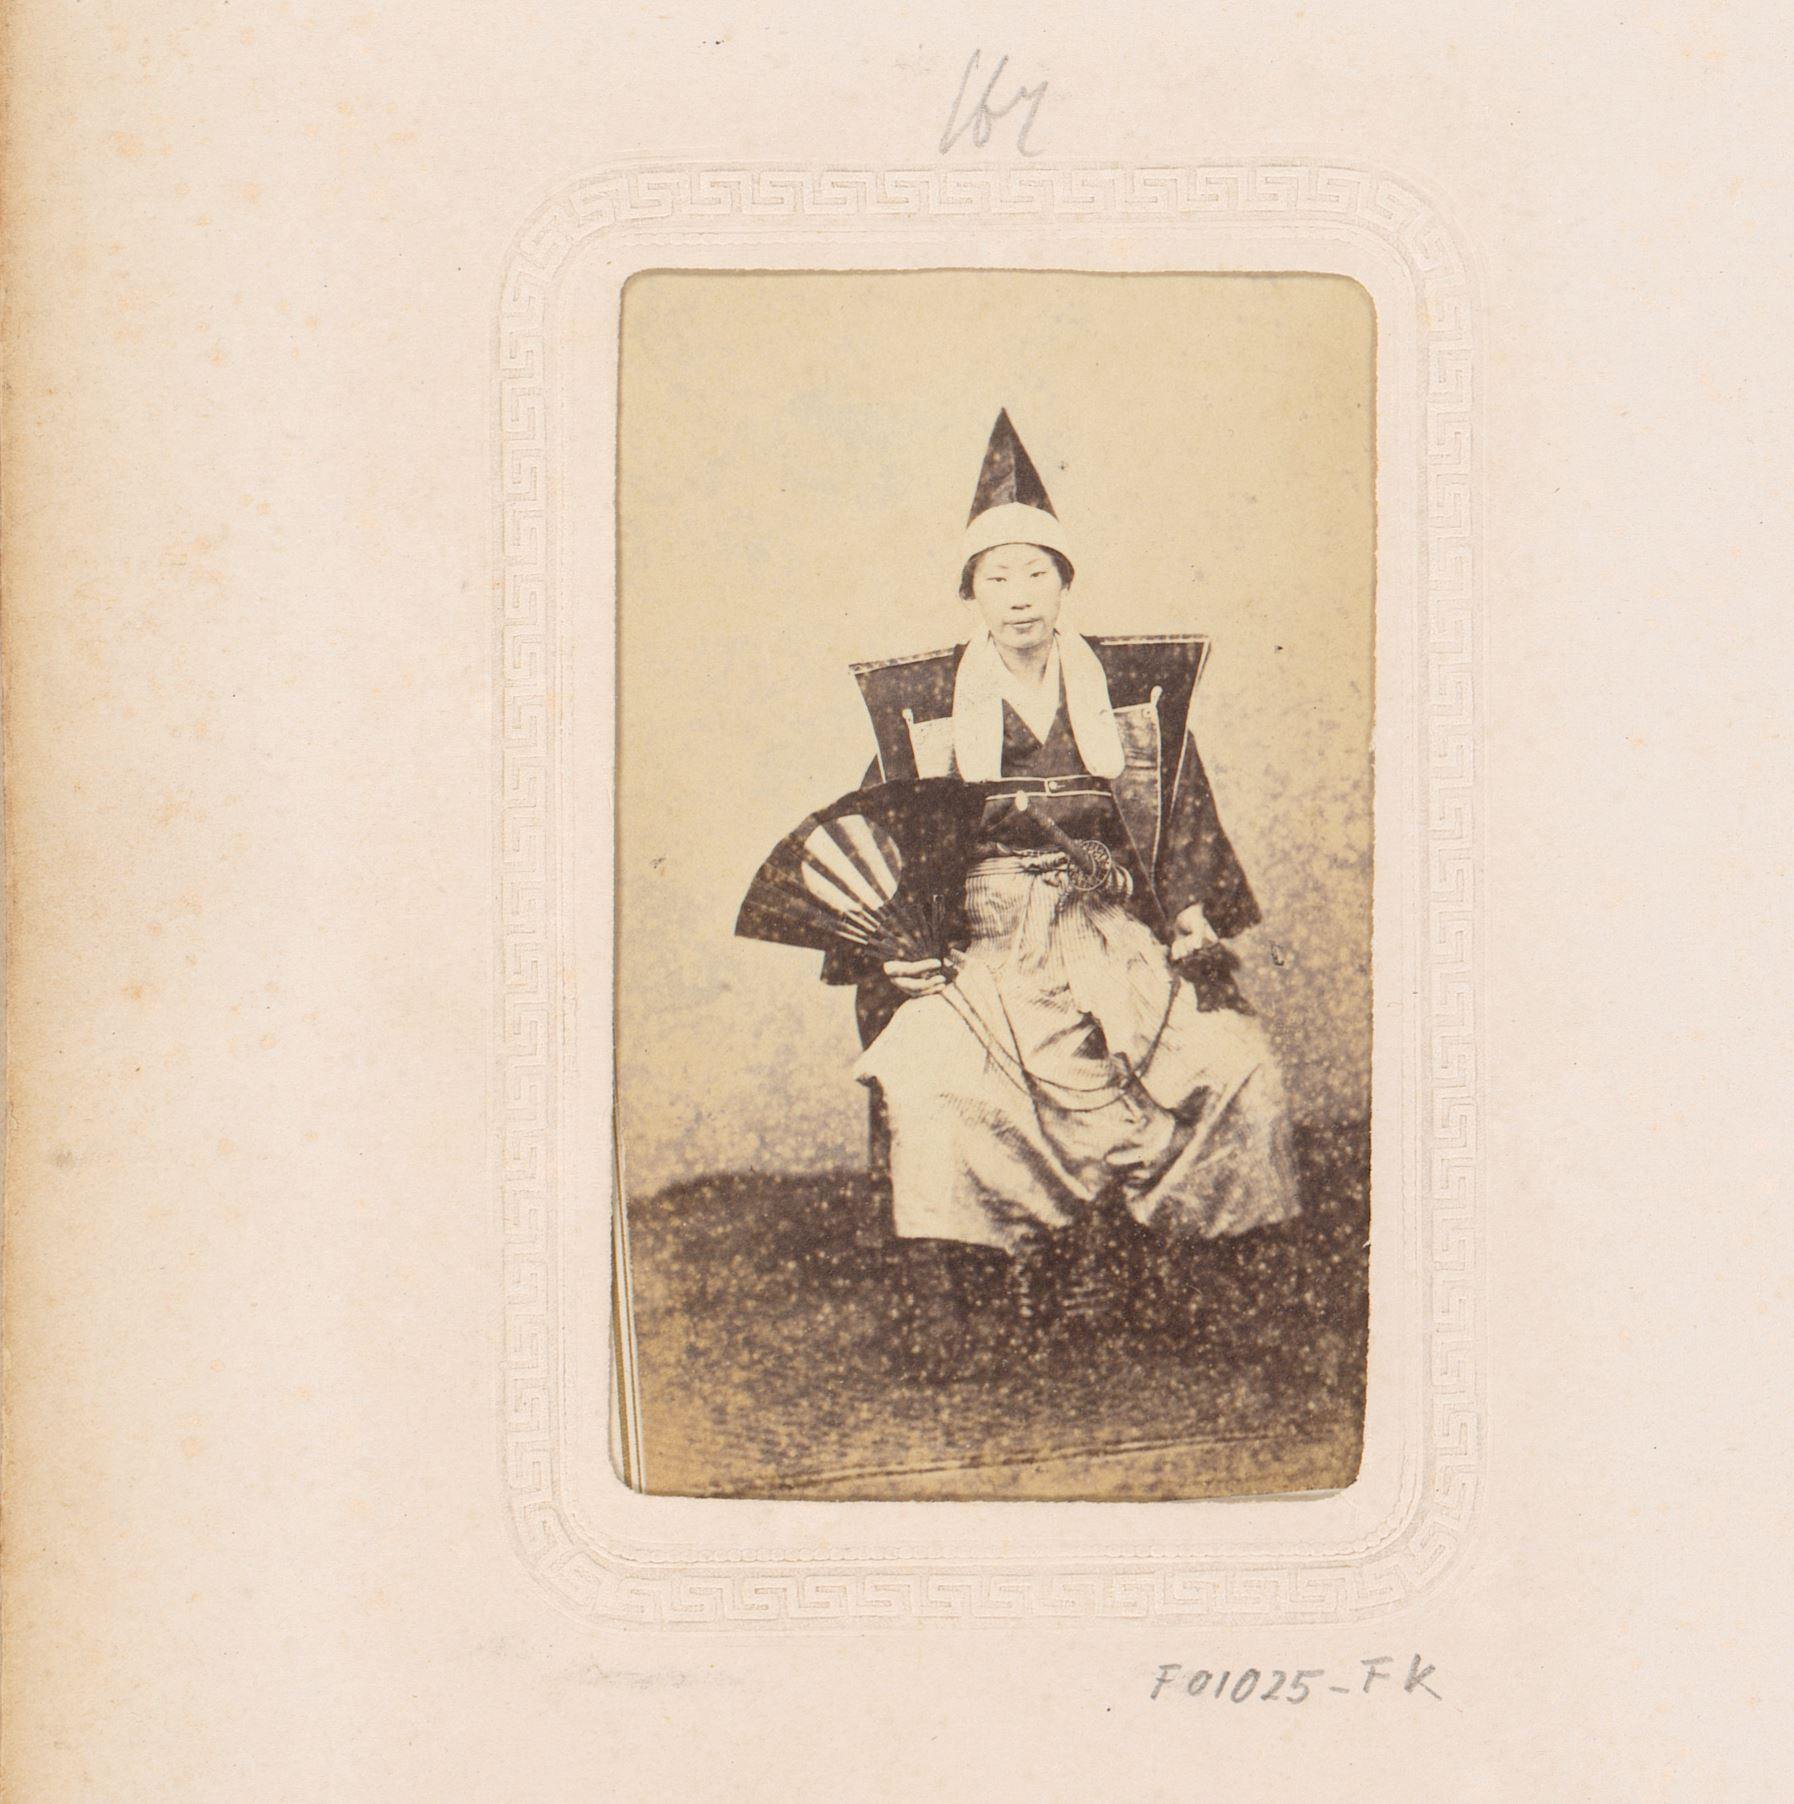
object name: photograph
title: Portret van een Japanse man met zwaard en waaier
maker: Anonymous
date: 1850-1880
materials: cardboard, photographic support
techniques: albumen print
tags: historical persons, hacking and thrusting weapons: sword, fan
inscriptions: number: ‘167’